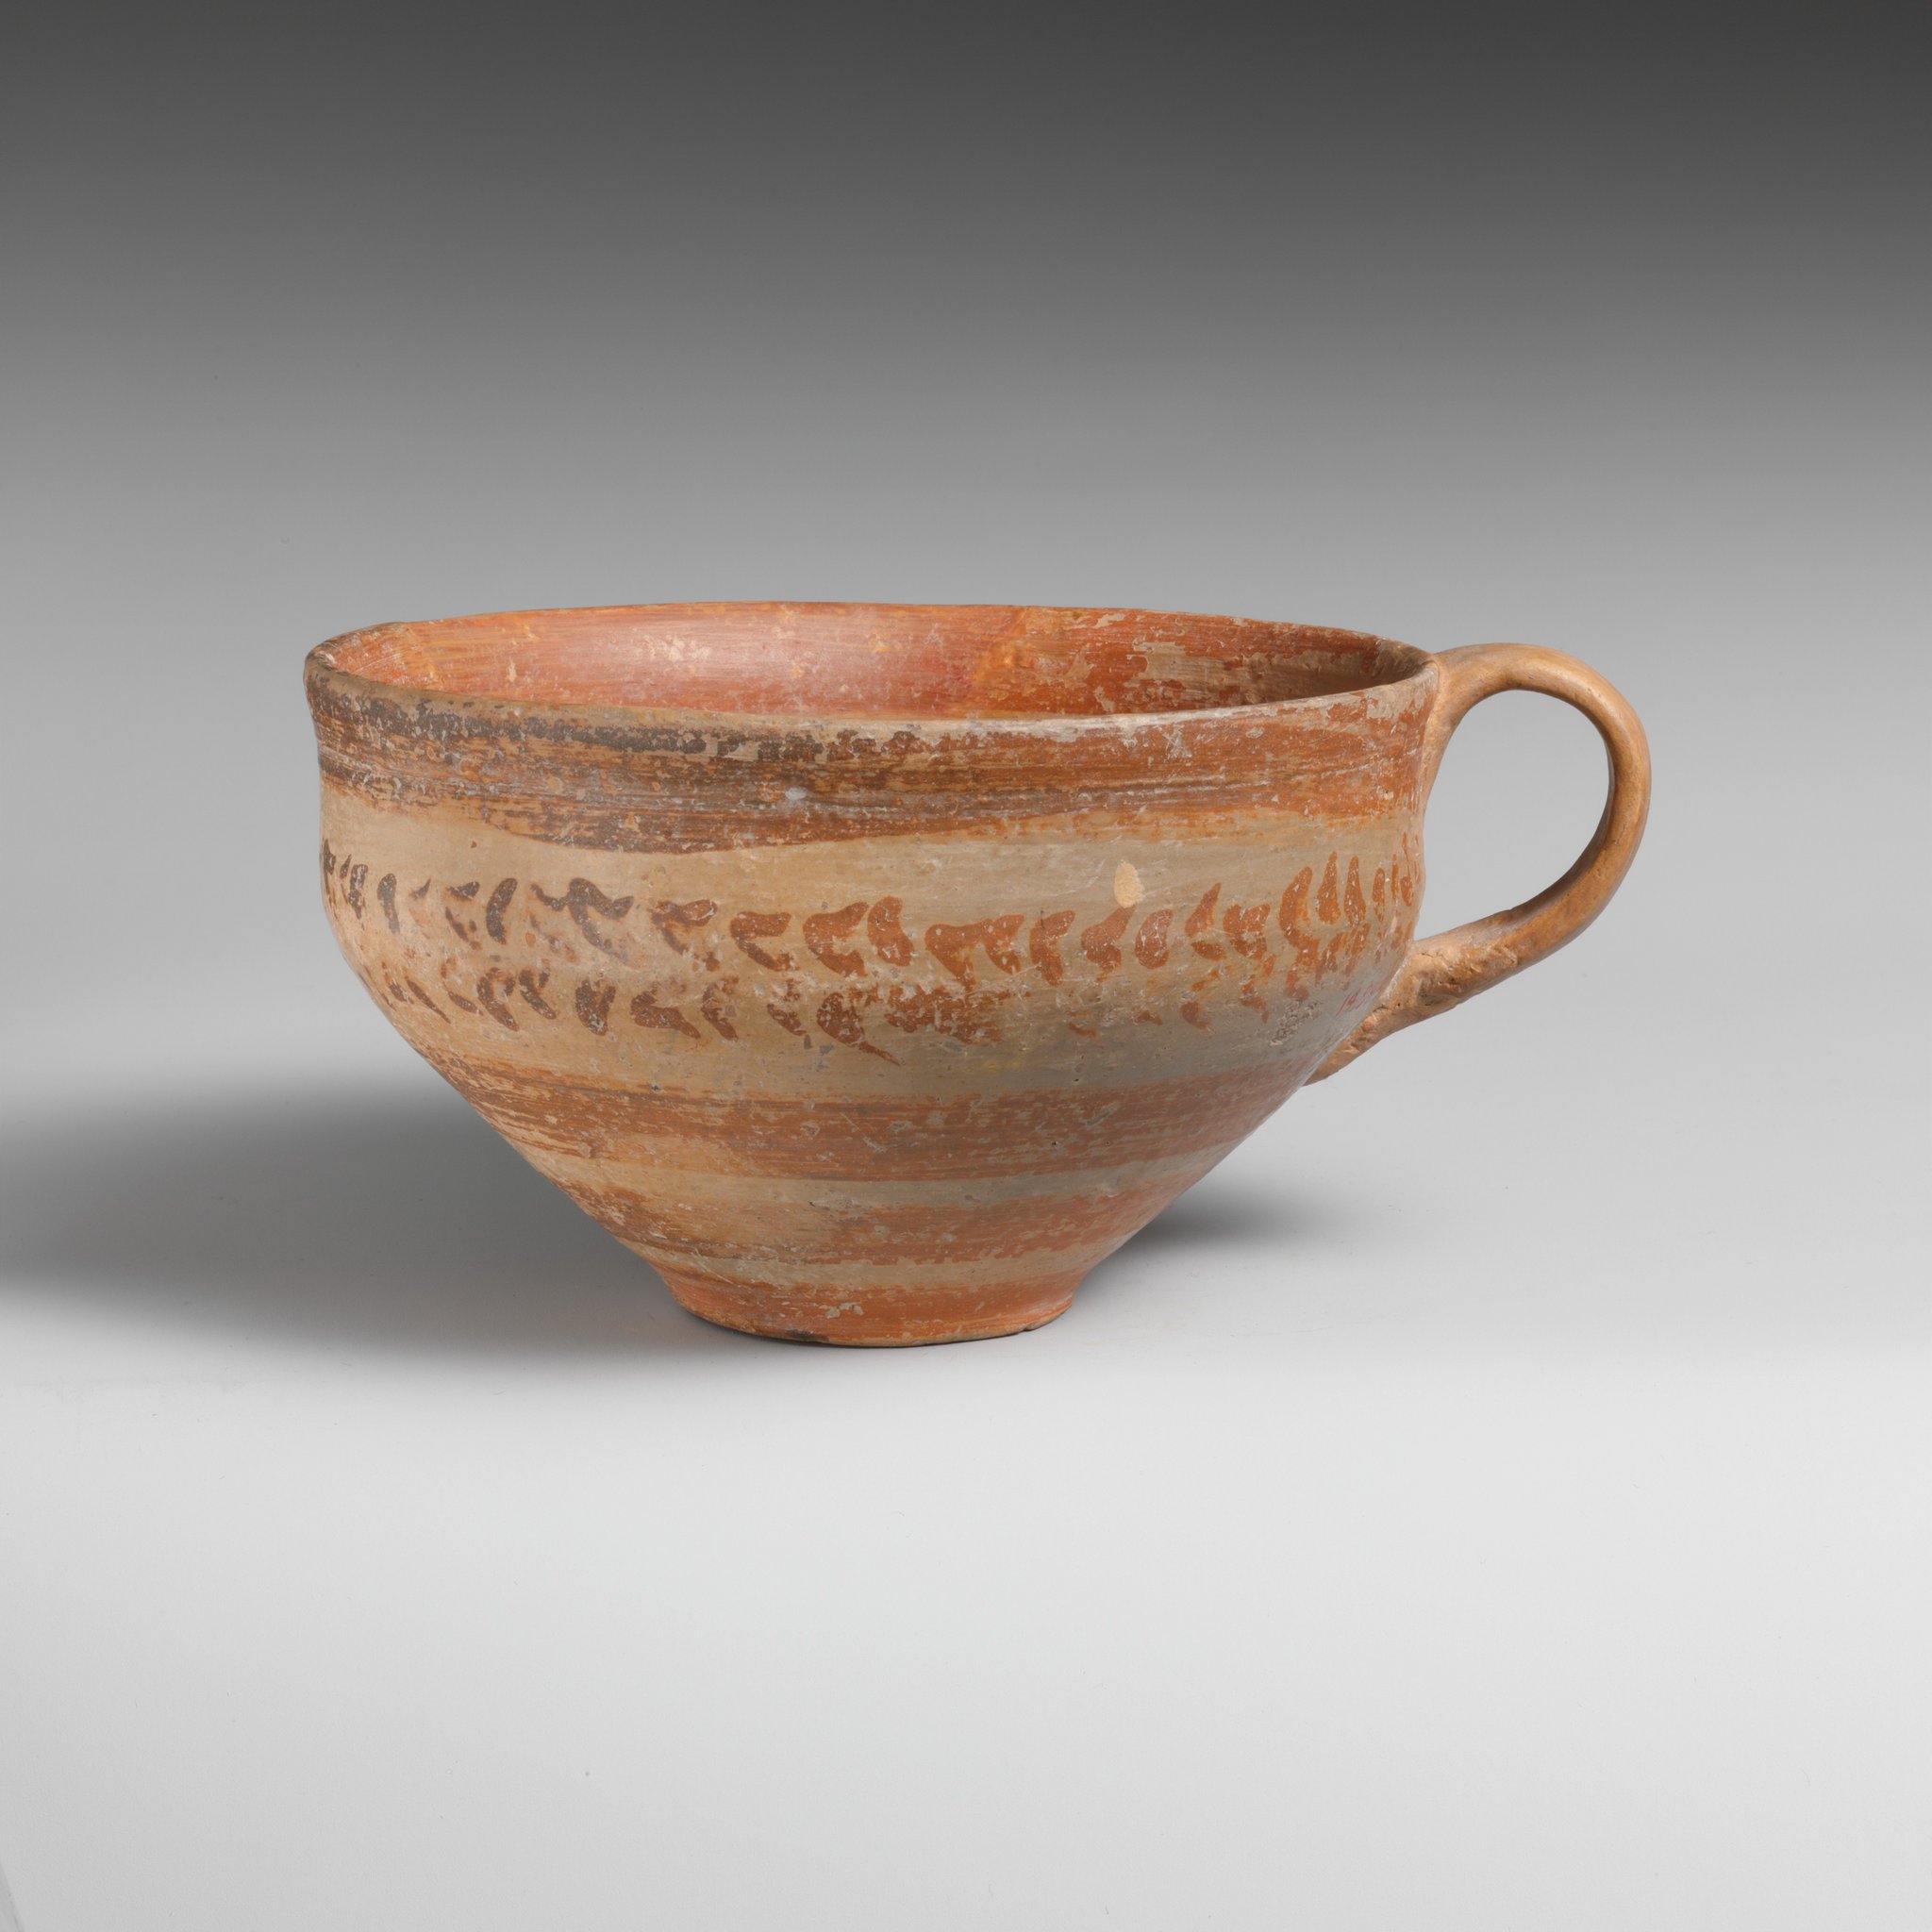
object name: cup, one handled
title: Terracotta hemispherical cup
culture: minoan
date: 1525-1450 BCE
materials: terracotta